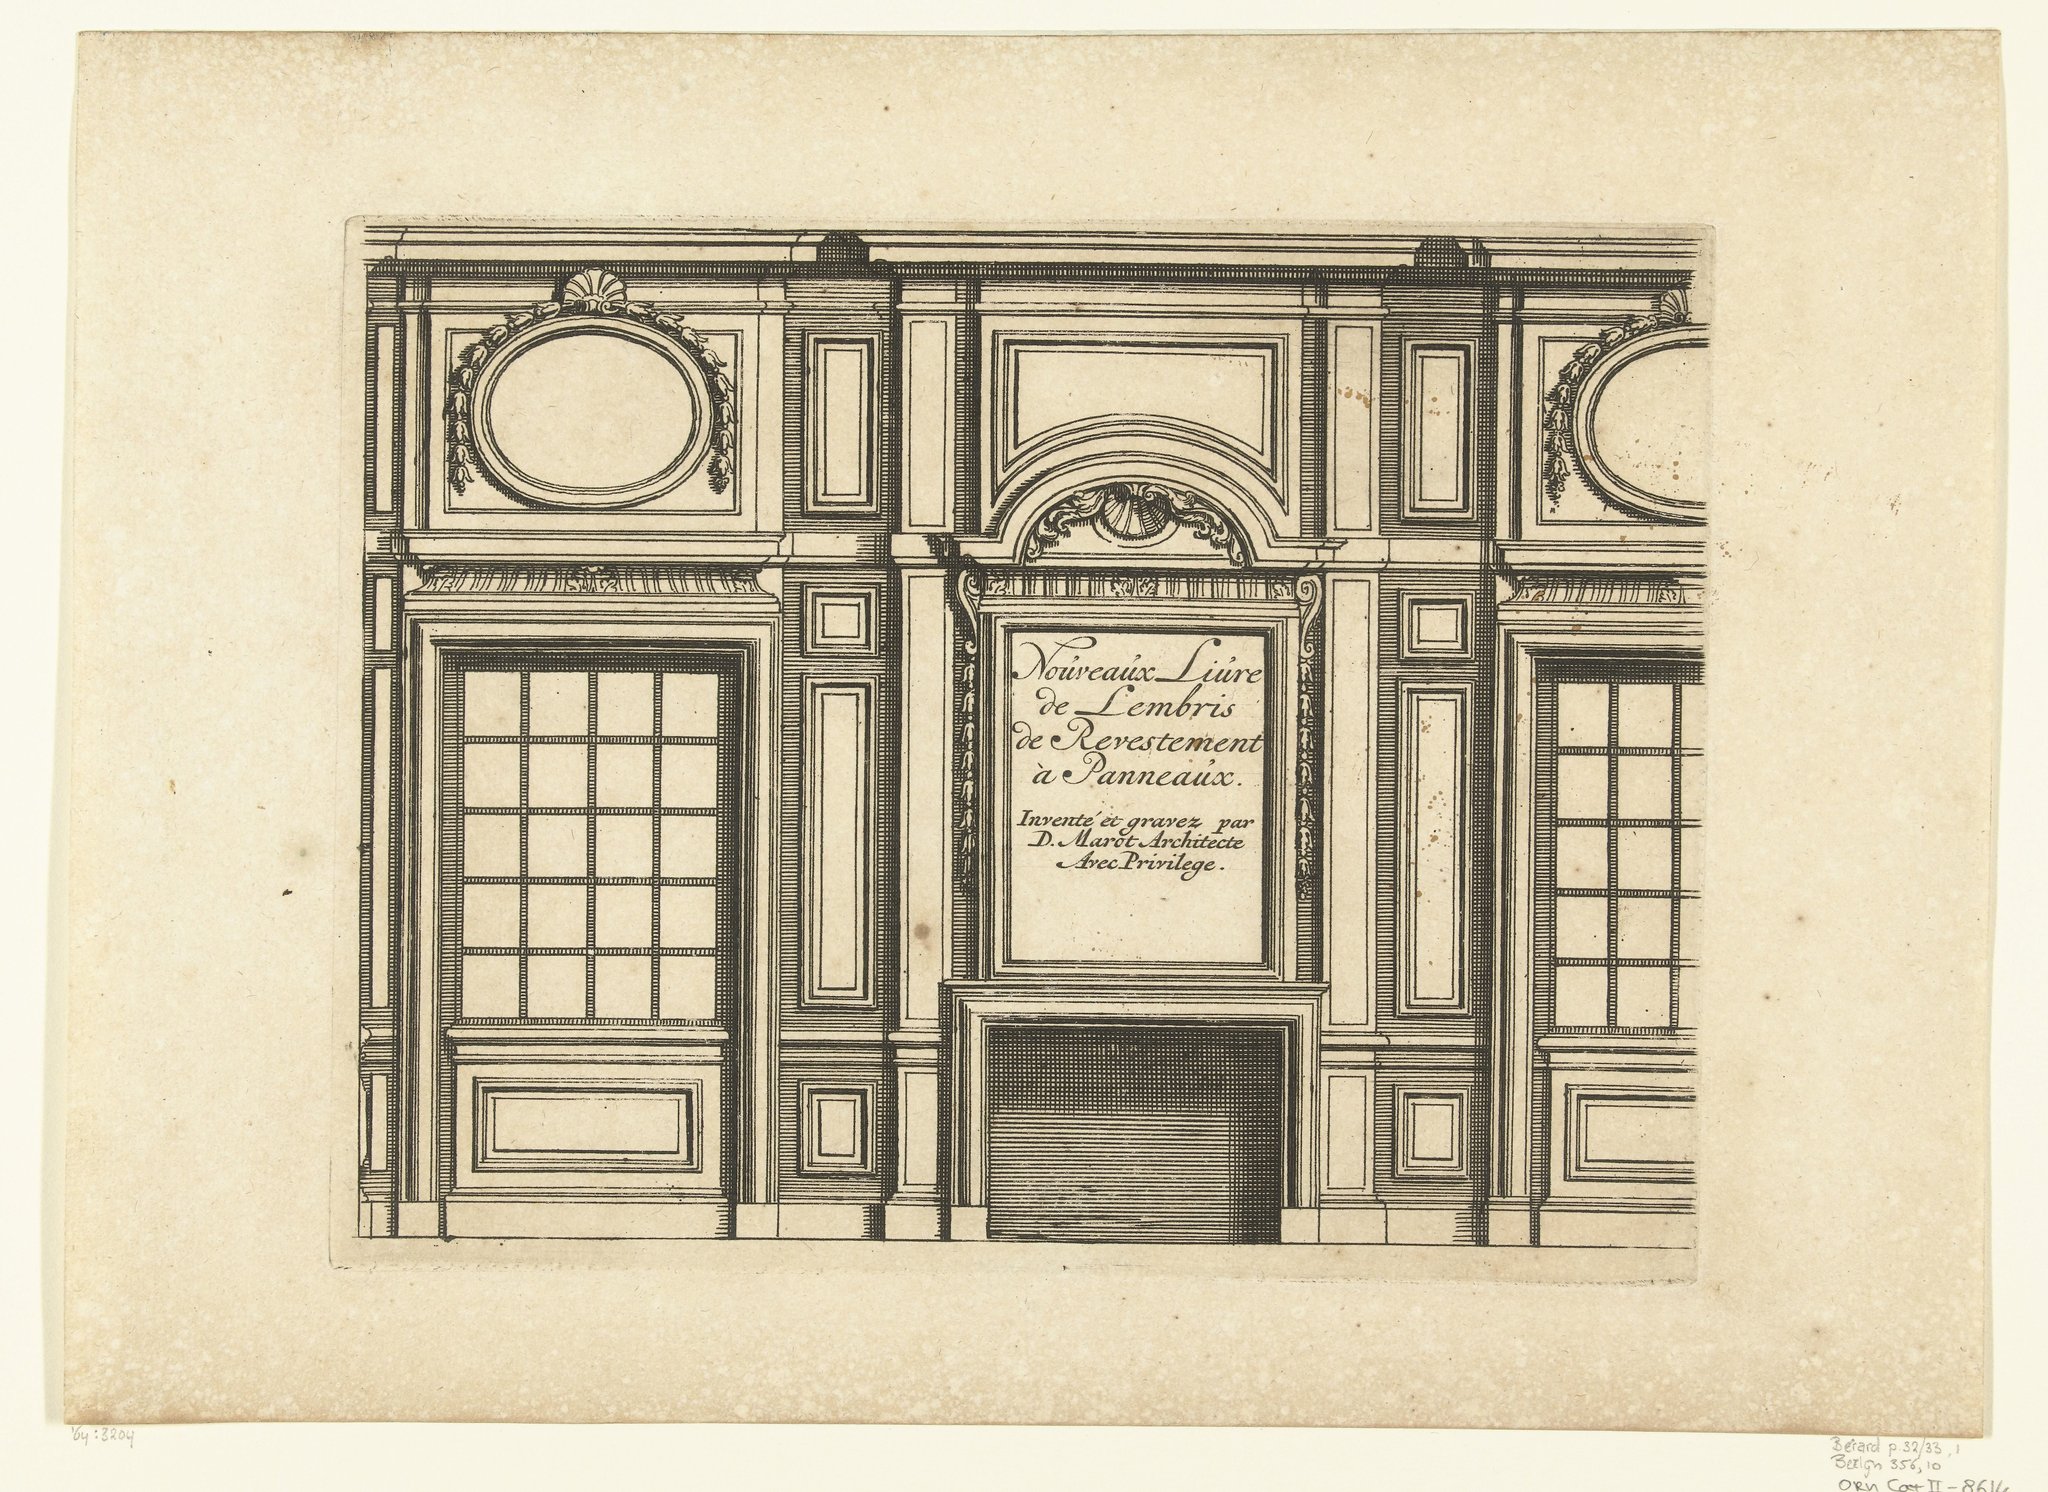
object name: ornament print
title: Titelblad: Nouveaux Liure de Lembris et Revestement à Panneaux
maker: daniël marot (i)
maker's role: draughtsman, print maker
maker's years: 1661-1752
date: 1703-1712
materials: paper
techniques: etching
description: Muur met een schoorsteen tussen twee ramen. Op de spiegel staat de titel. Uit serie van 6 bladen.